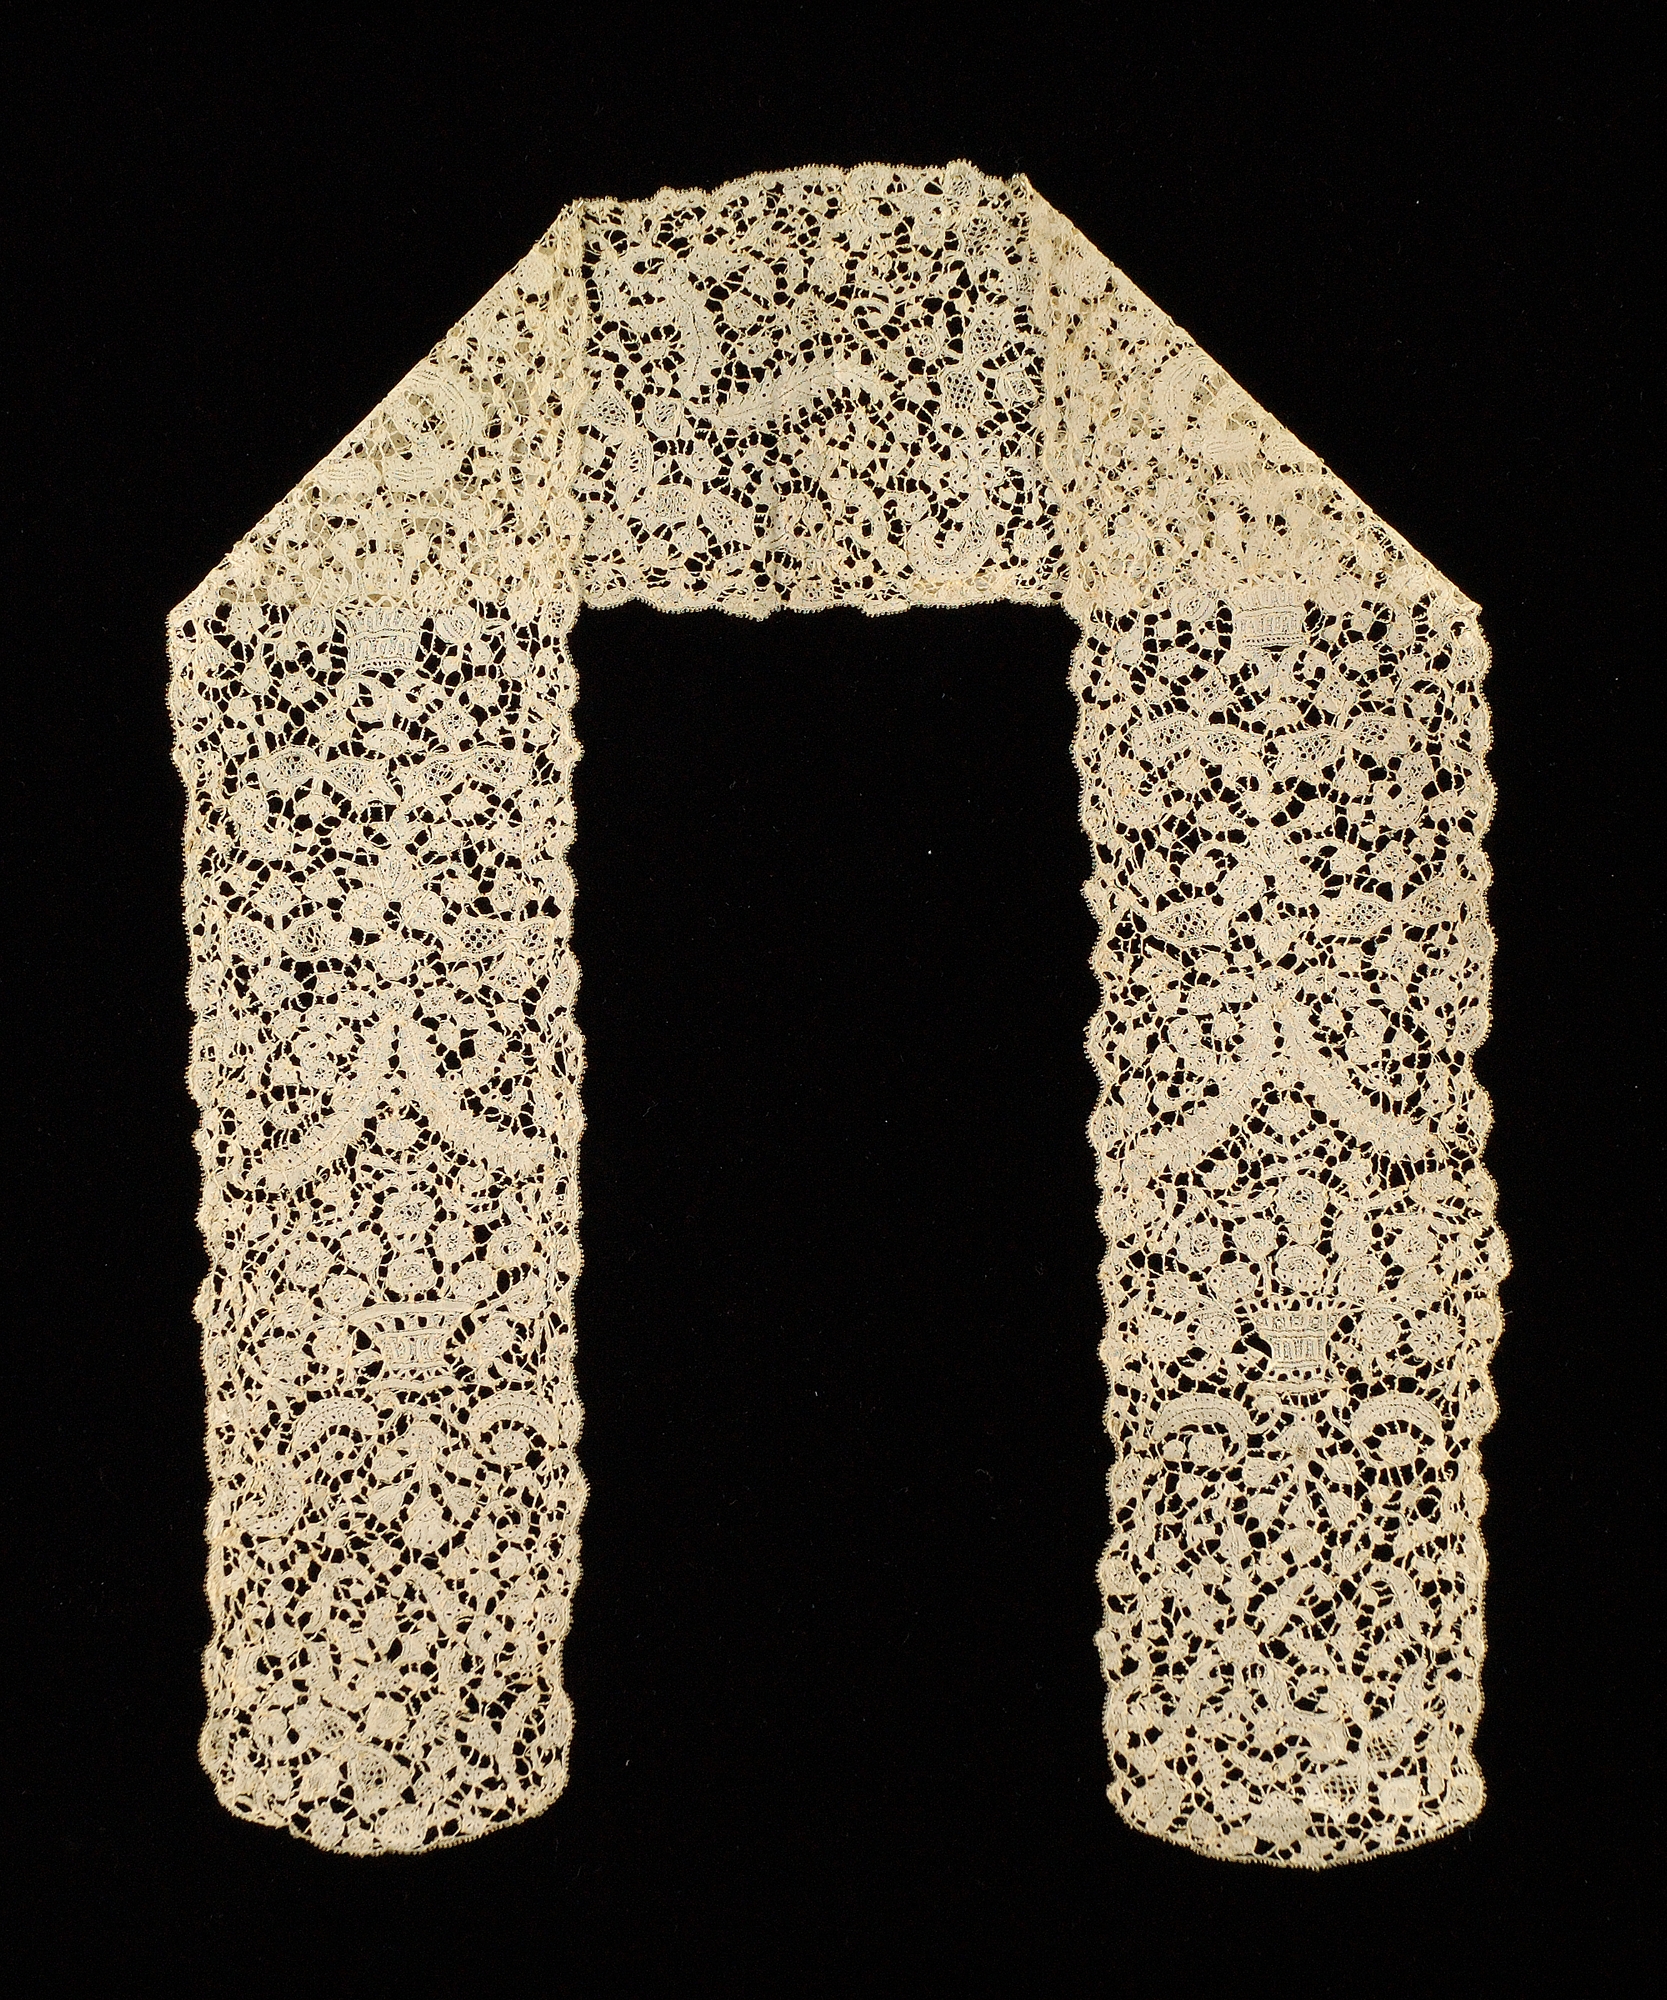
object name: lappet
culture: european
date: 1701-1733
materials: linen